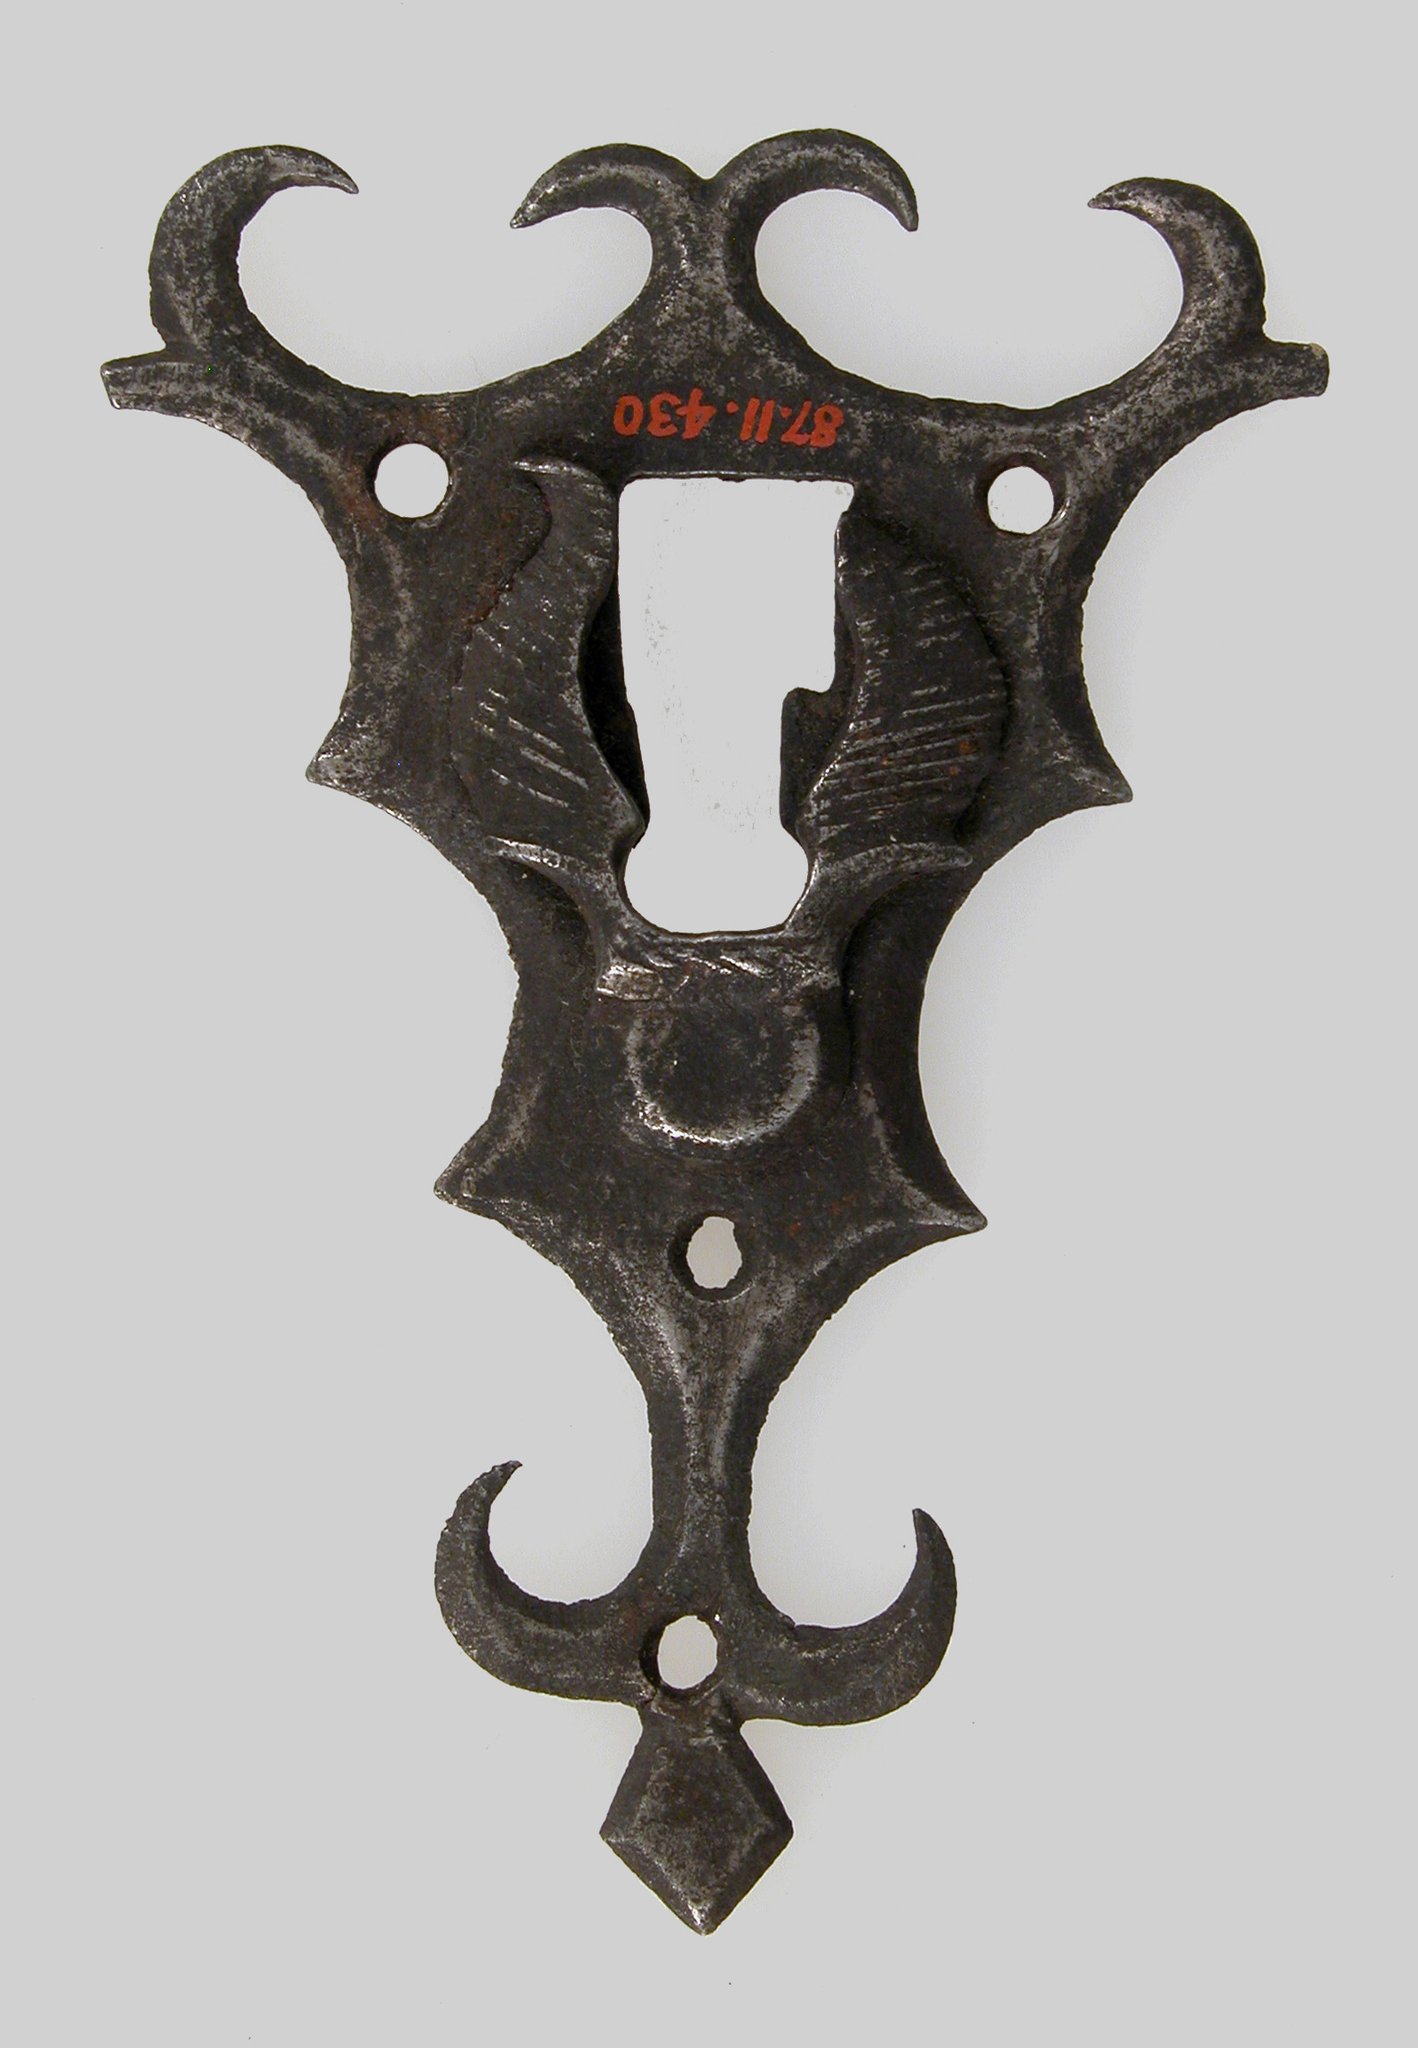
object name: escutcheon plate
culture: german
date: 1501-1600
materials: iron